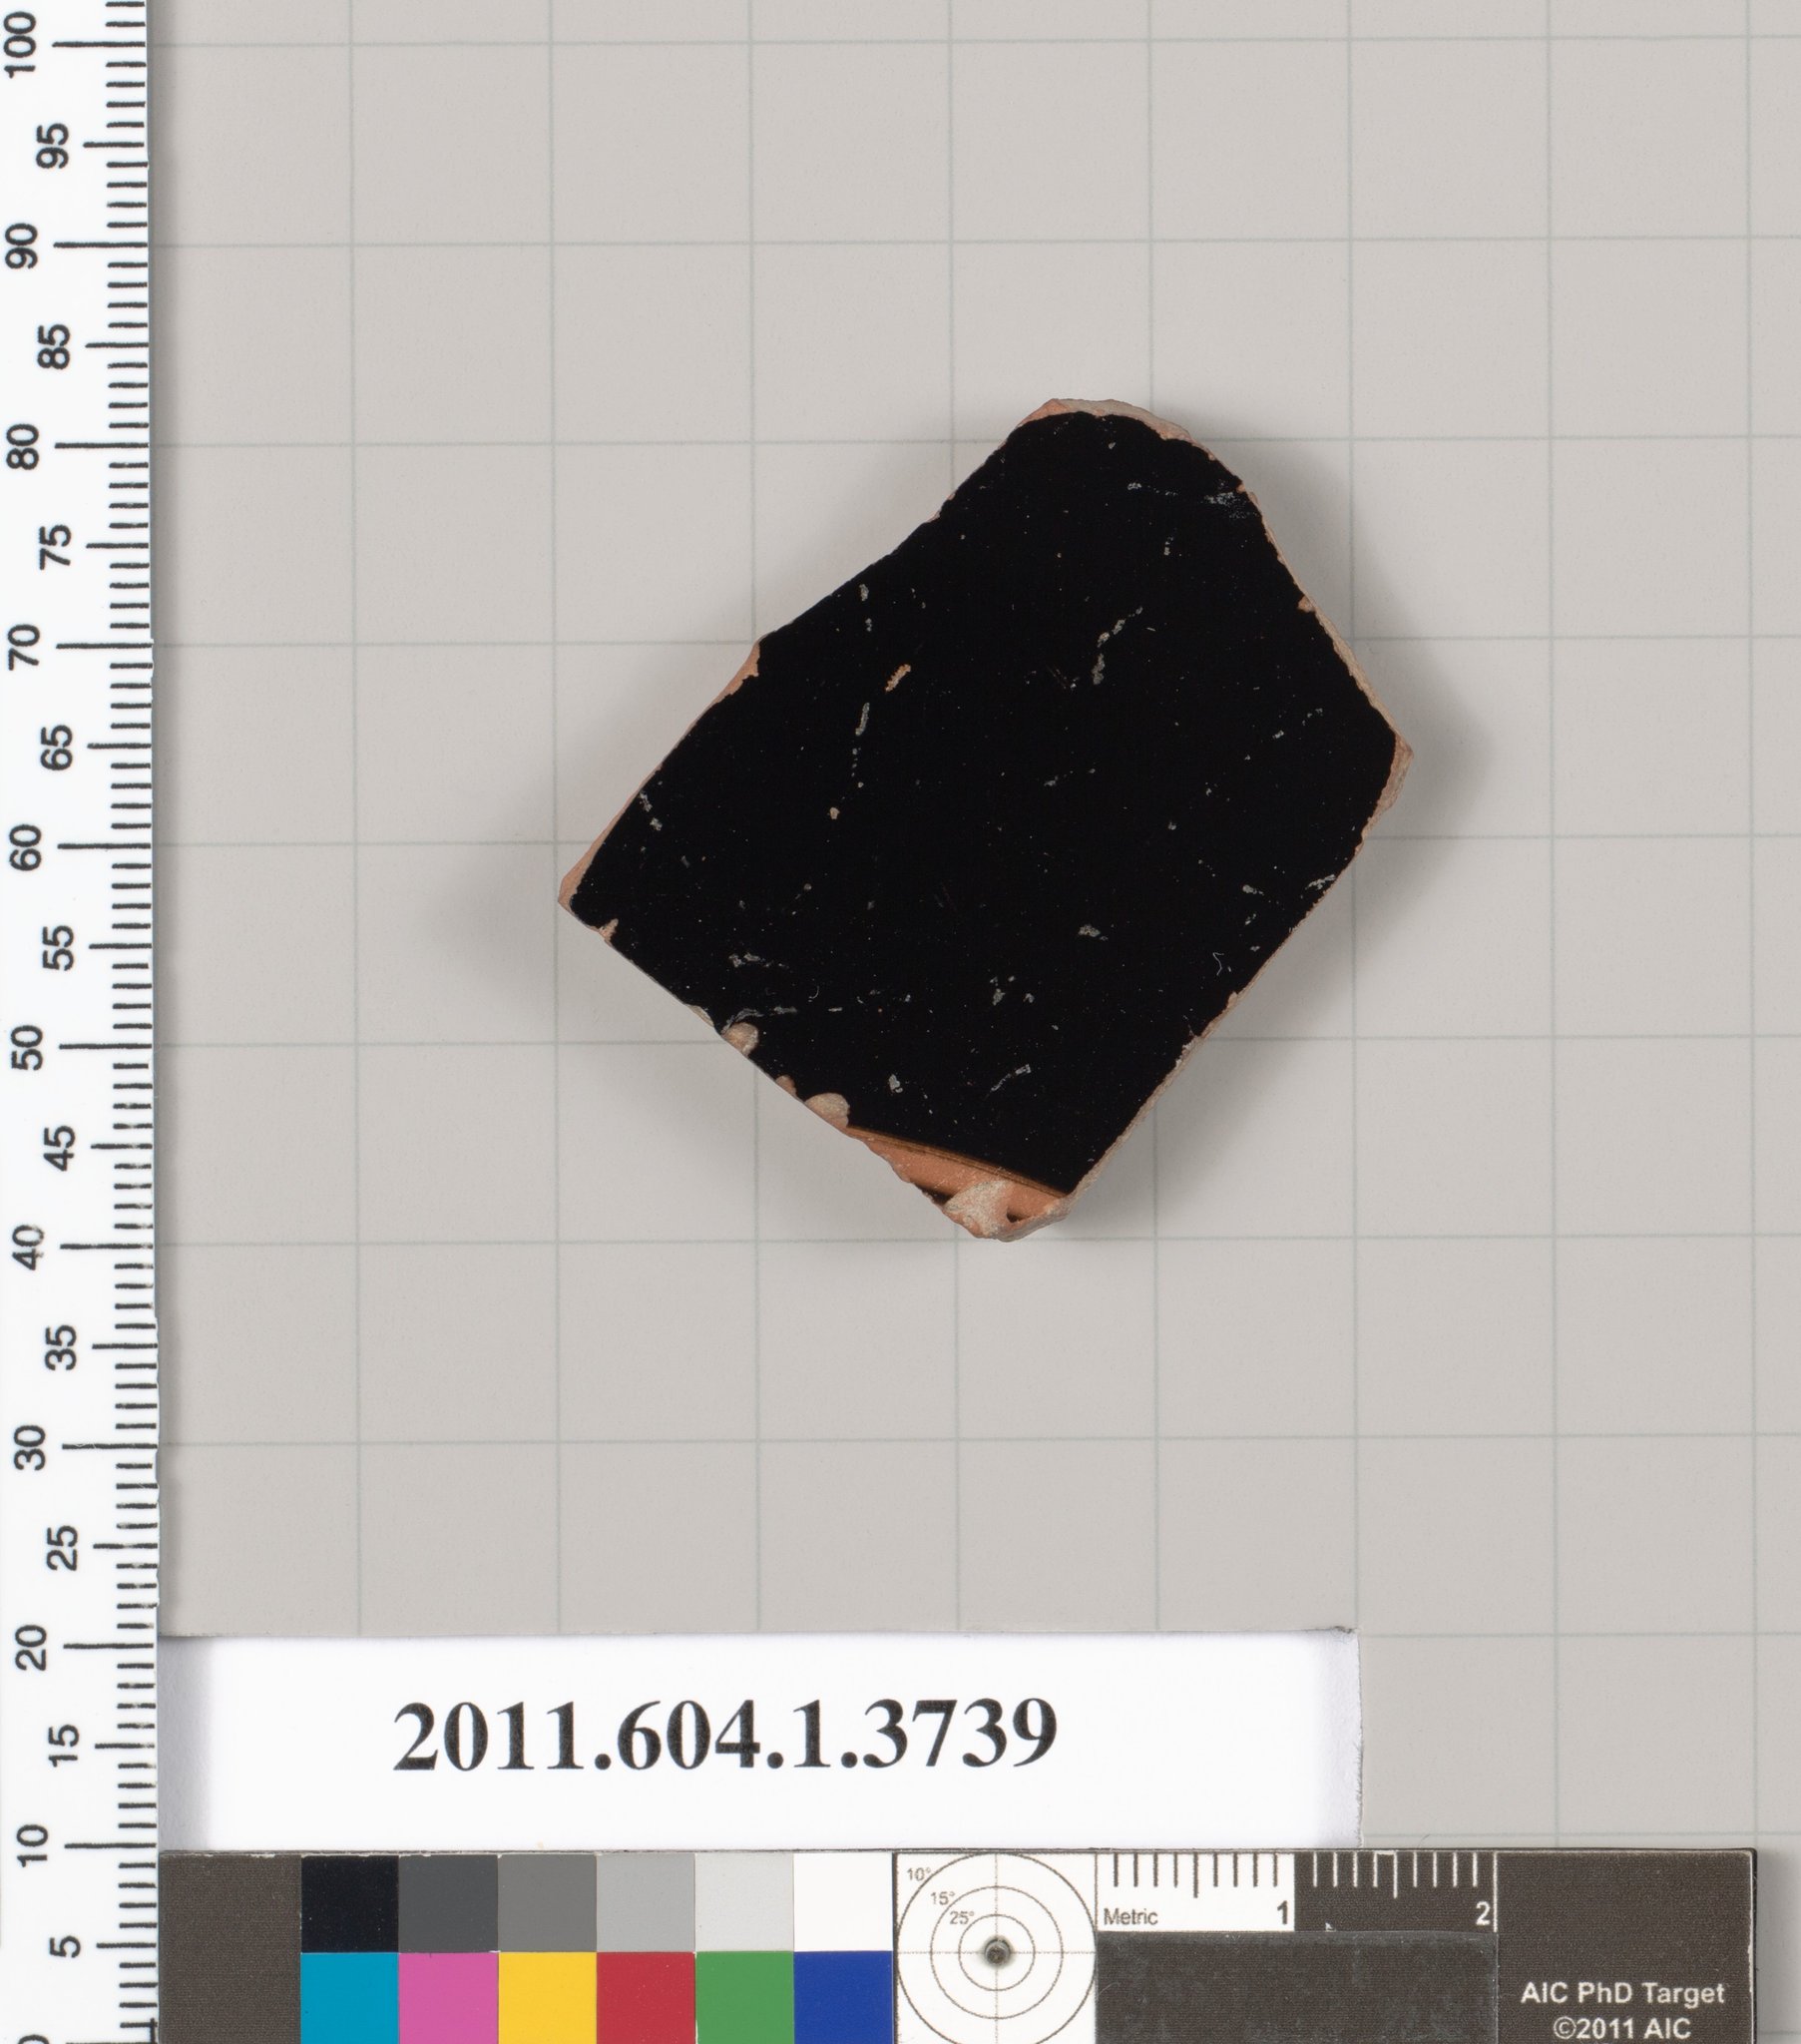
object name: kylix fragment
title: Terracotta fragment of a kylix (drinking cup)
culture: greek, attic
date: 490-470 BCE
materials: terracotta